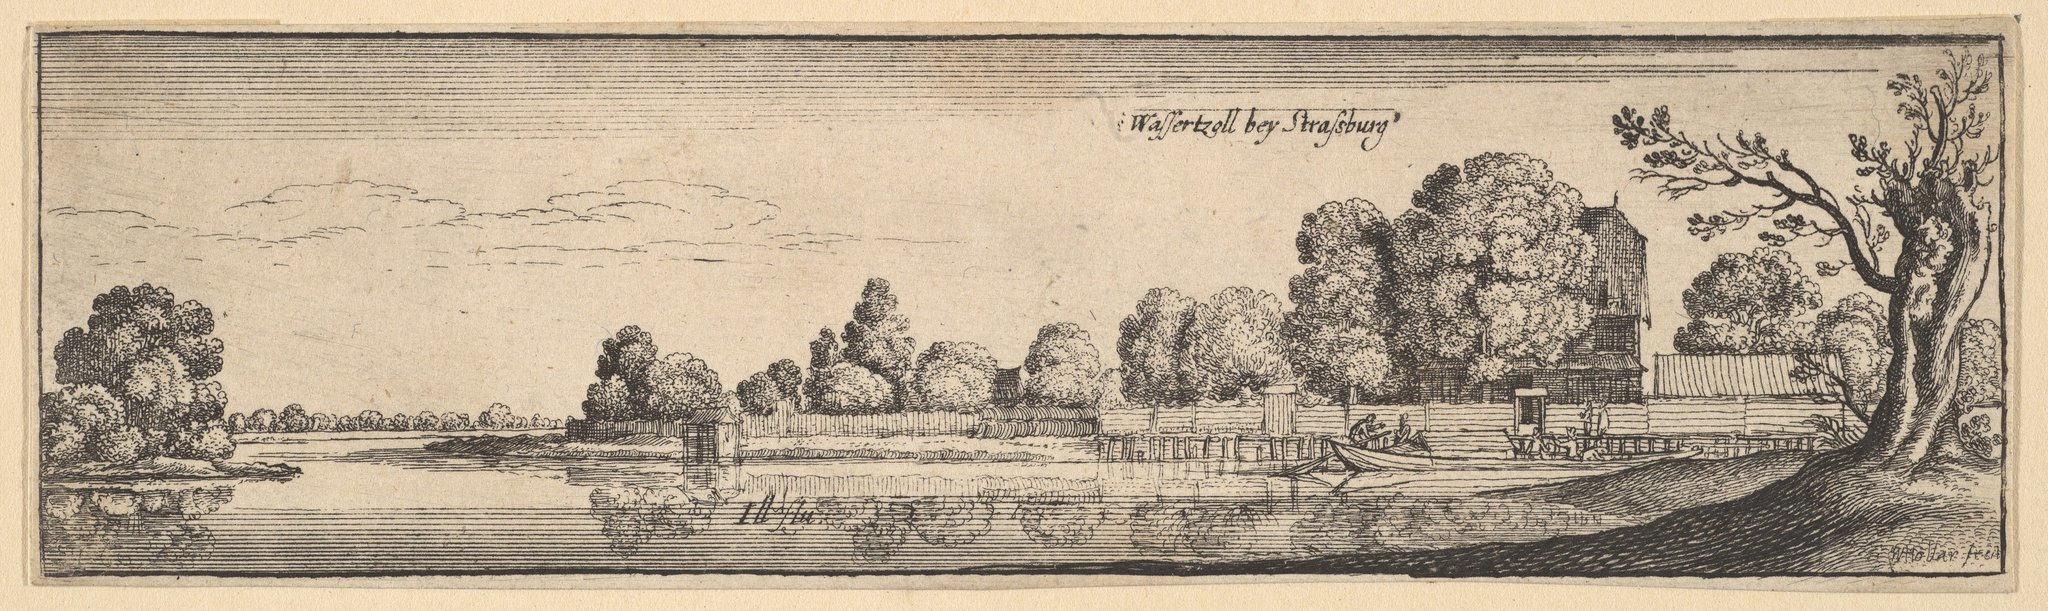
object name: print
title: Strasbourg: The Toll House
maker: wenceslaus hollar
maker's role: artist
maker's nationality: bohemian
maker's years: 1607-1677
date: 1625-1677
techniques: etching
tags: rivers,boats